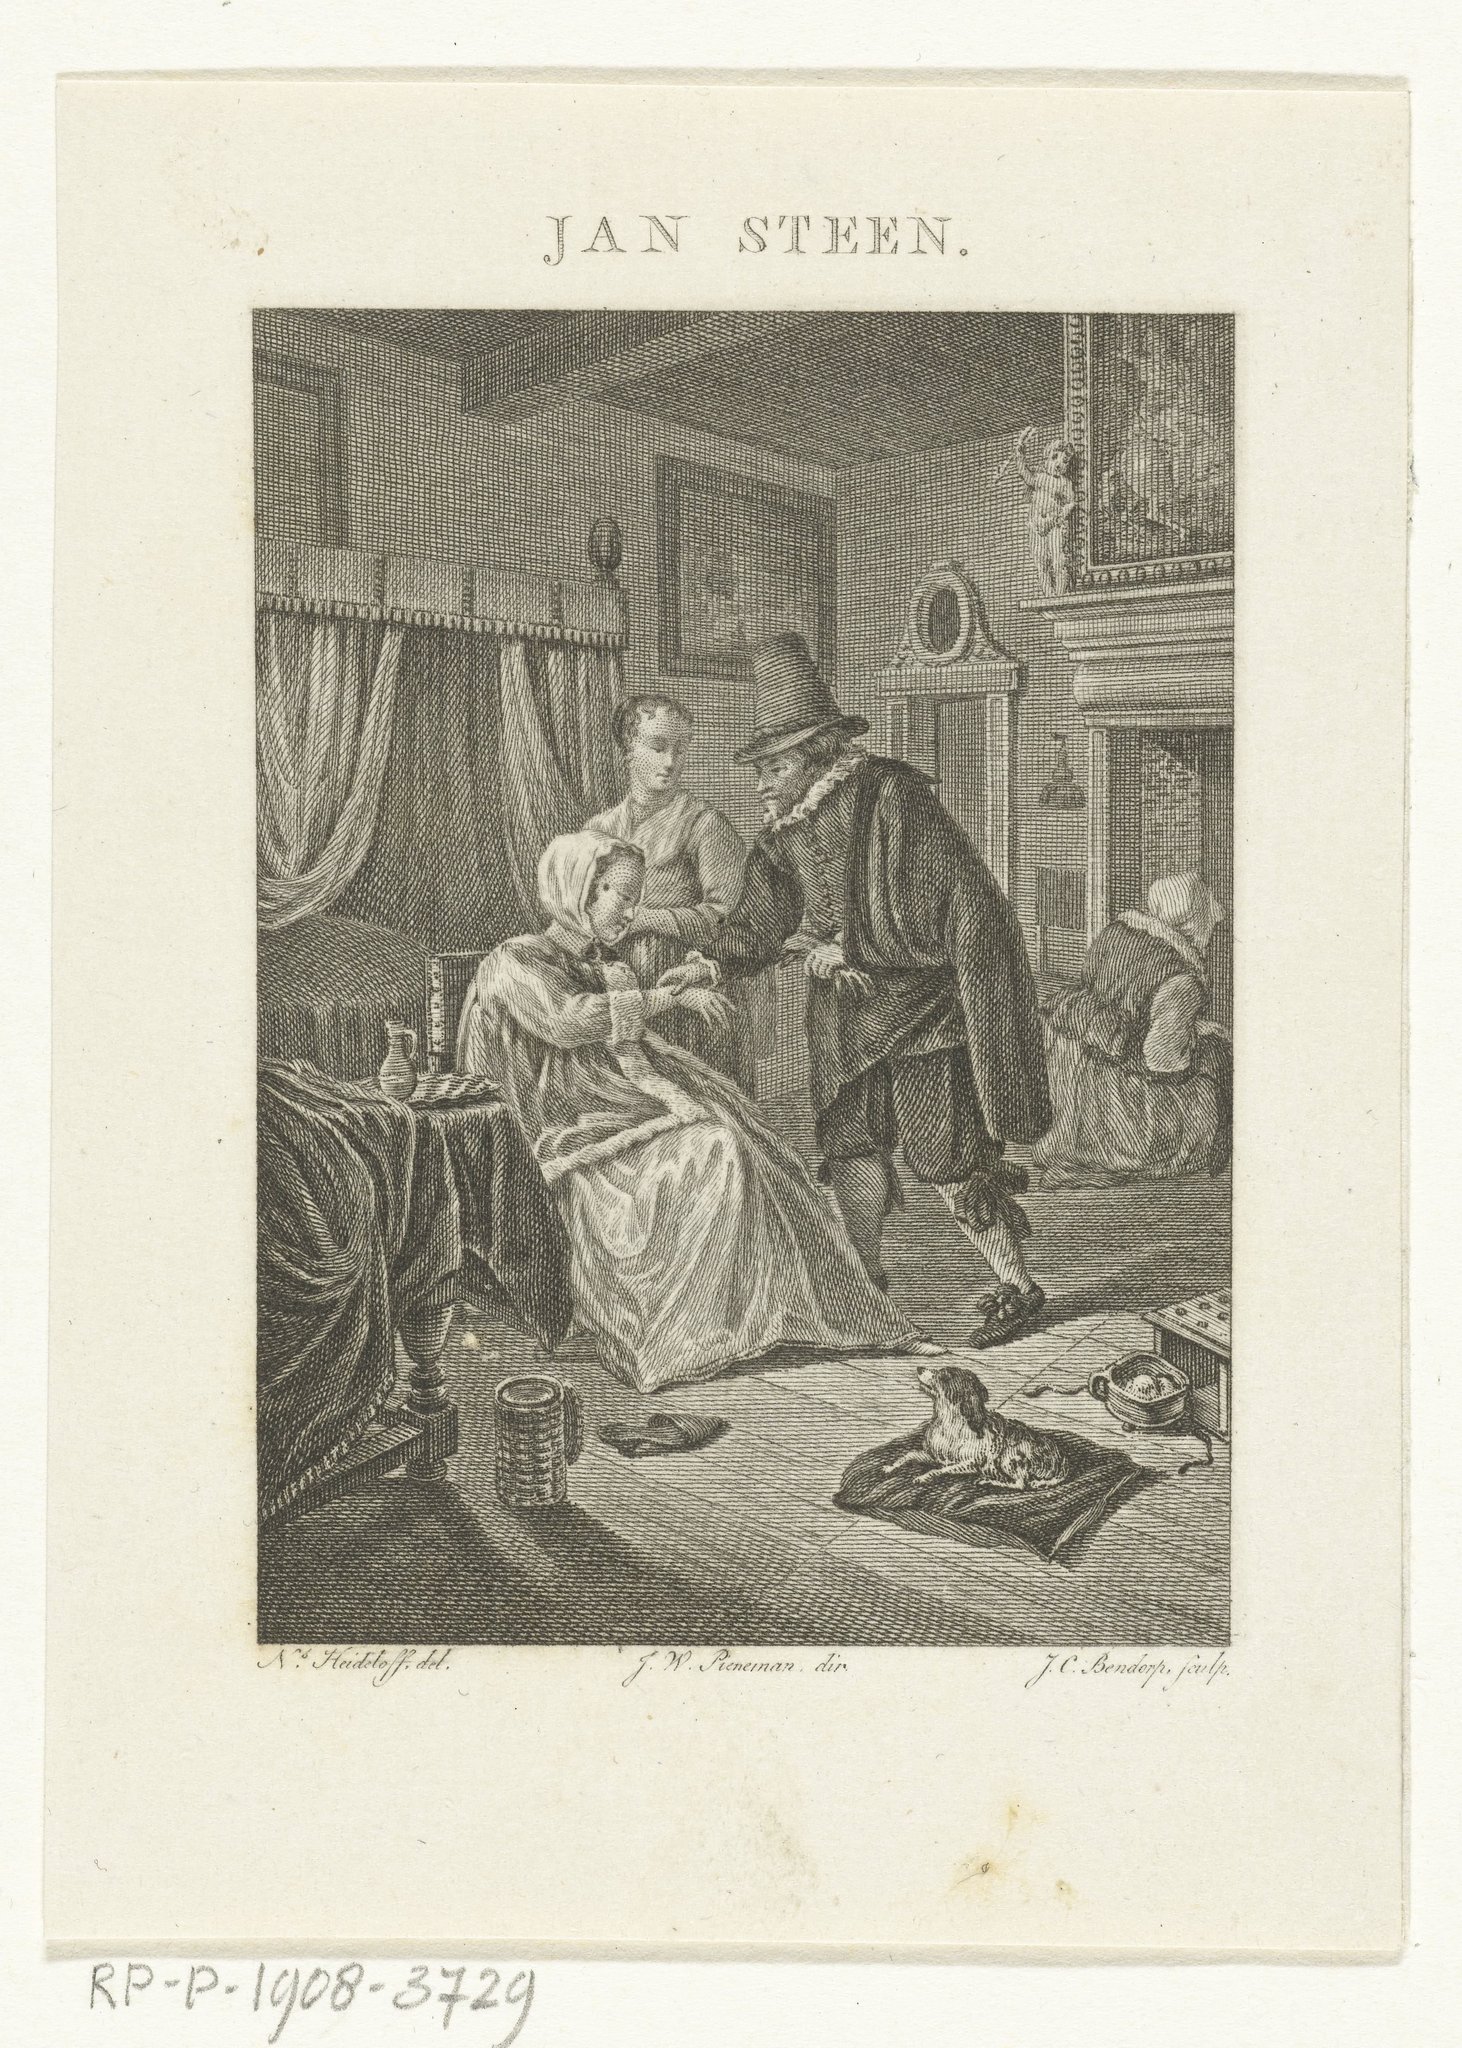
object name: print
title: Jan Steen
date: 1776-1819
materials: paper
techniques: etching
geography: netherlands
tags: feeling pulse or heart-beat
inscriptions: collector's mark: Lugt 2228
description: Prent naar tekening van N. Heideloff naar schilderij van Jan Steen. Prent uit: Nederlandsche muzen-almanak, Johannes Immerzeel (uitgever), Rotterdam 1819.